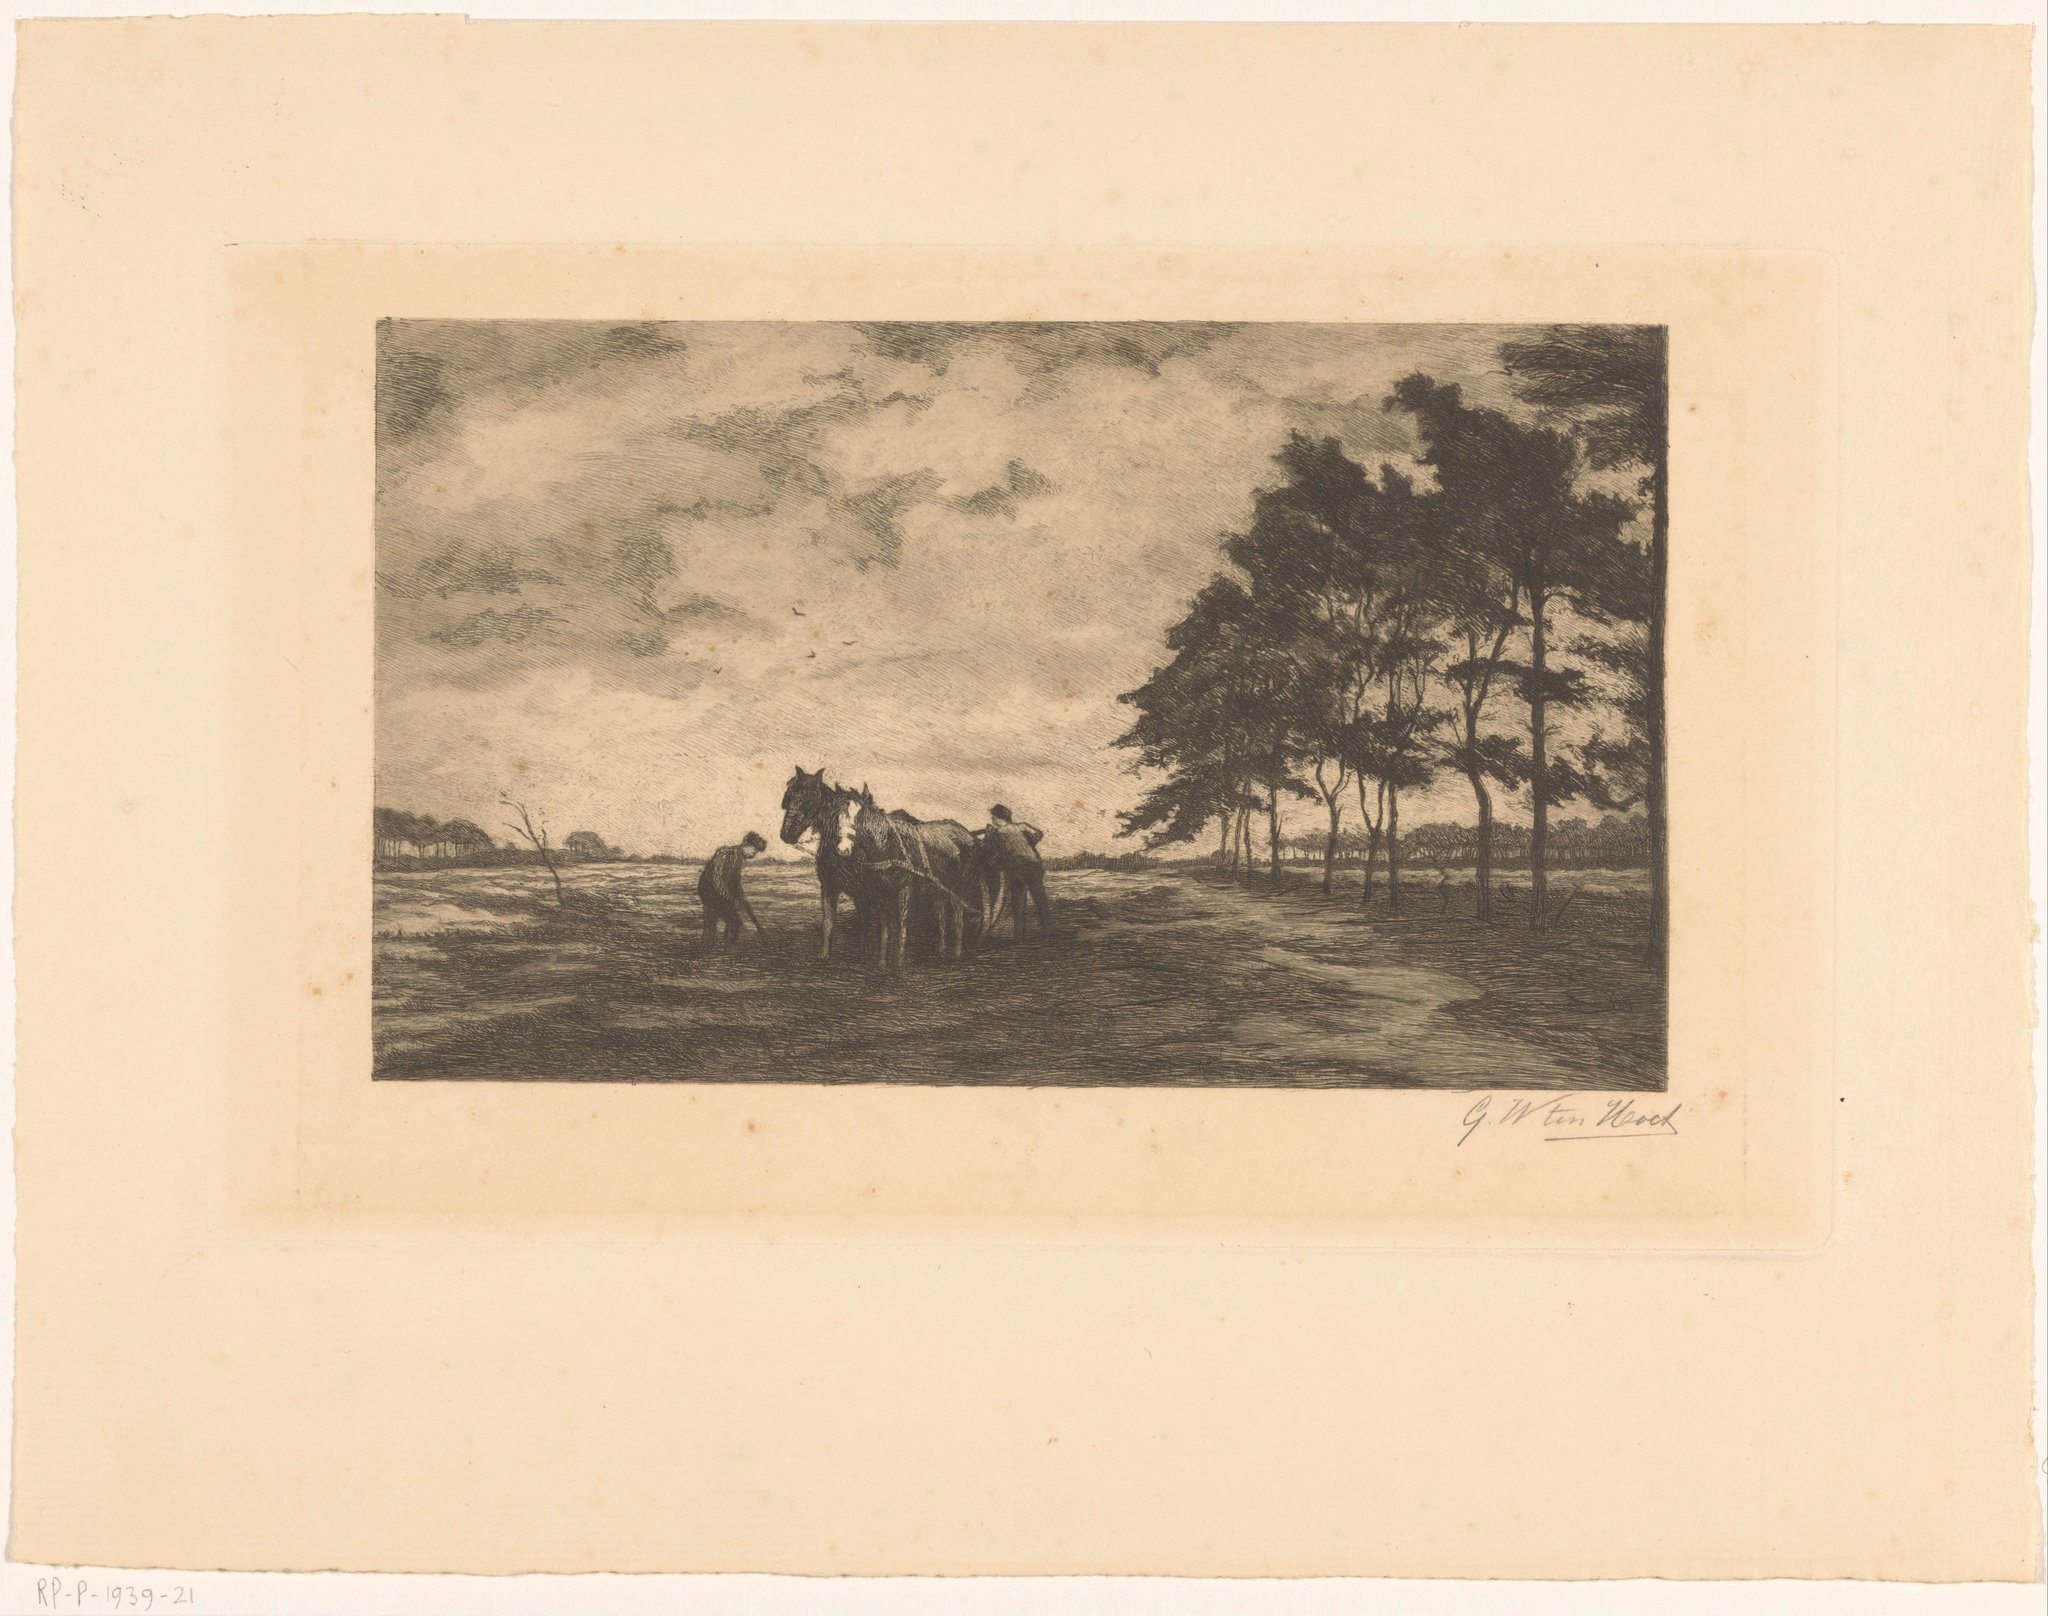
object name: print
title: Heidelandschap met paardenspan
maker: gerarda wilhelmina ten hoet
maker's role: print maker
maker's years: 1857-1939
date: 1867-1939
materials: paper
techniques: etching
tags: spading ~ soil cultivation, horse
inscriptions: collector's mark: Lugt 2228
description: Links naast de paarden is een man aan het plaggen. Rechts een rij bomen.